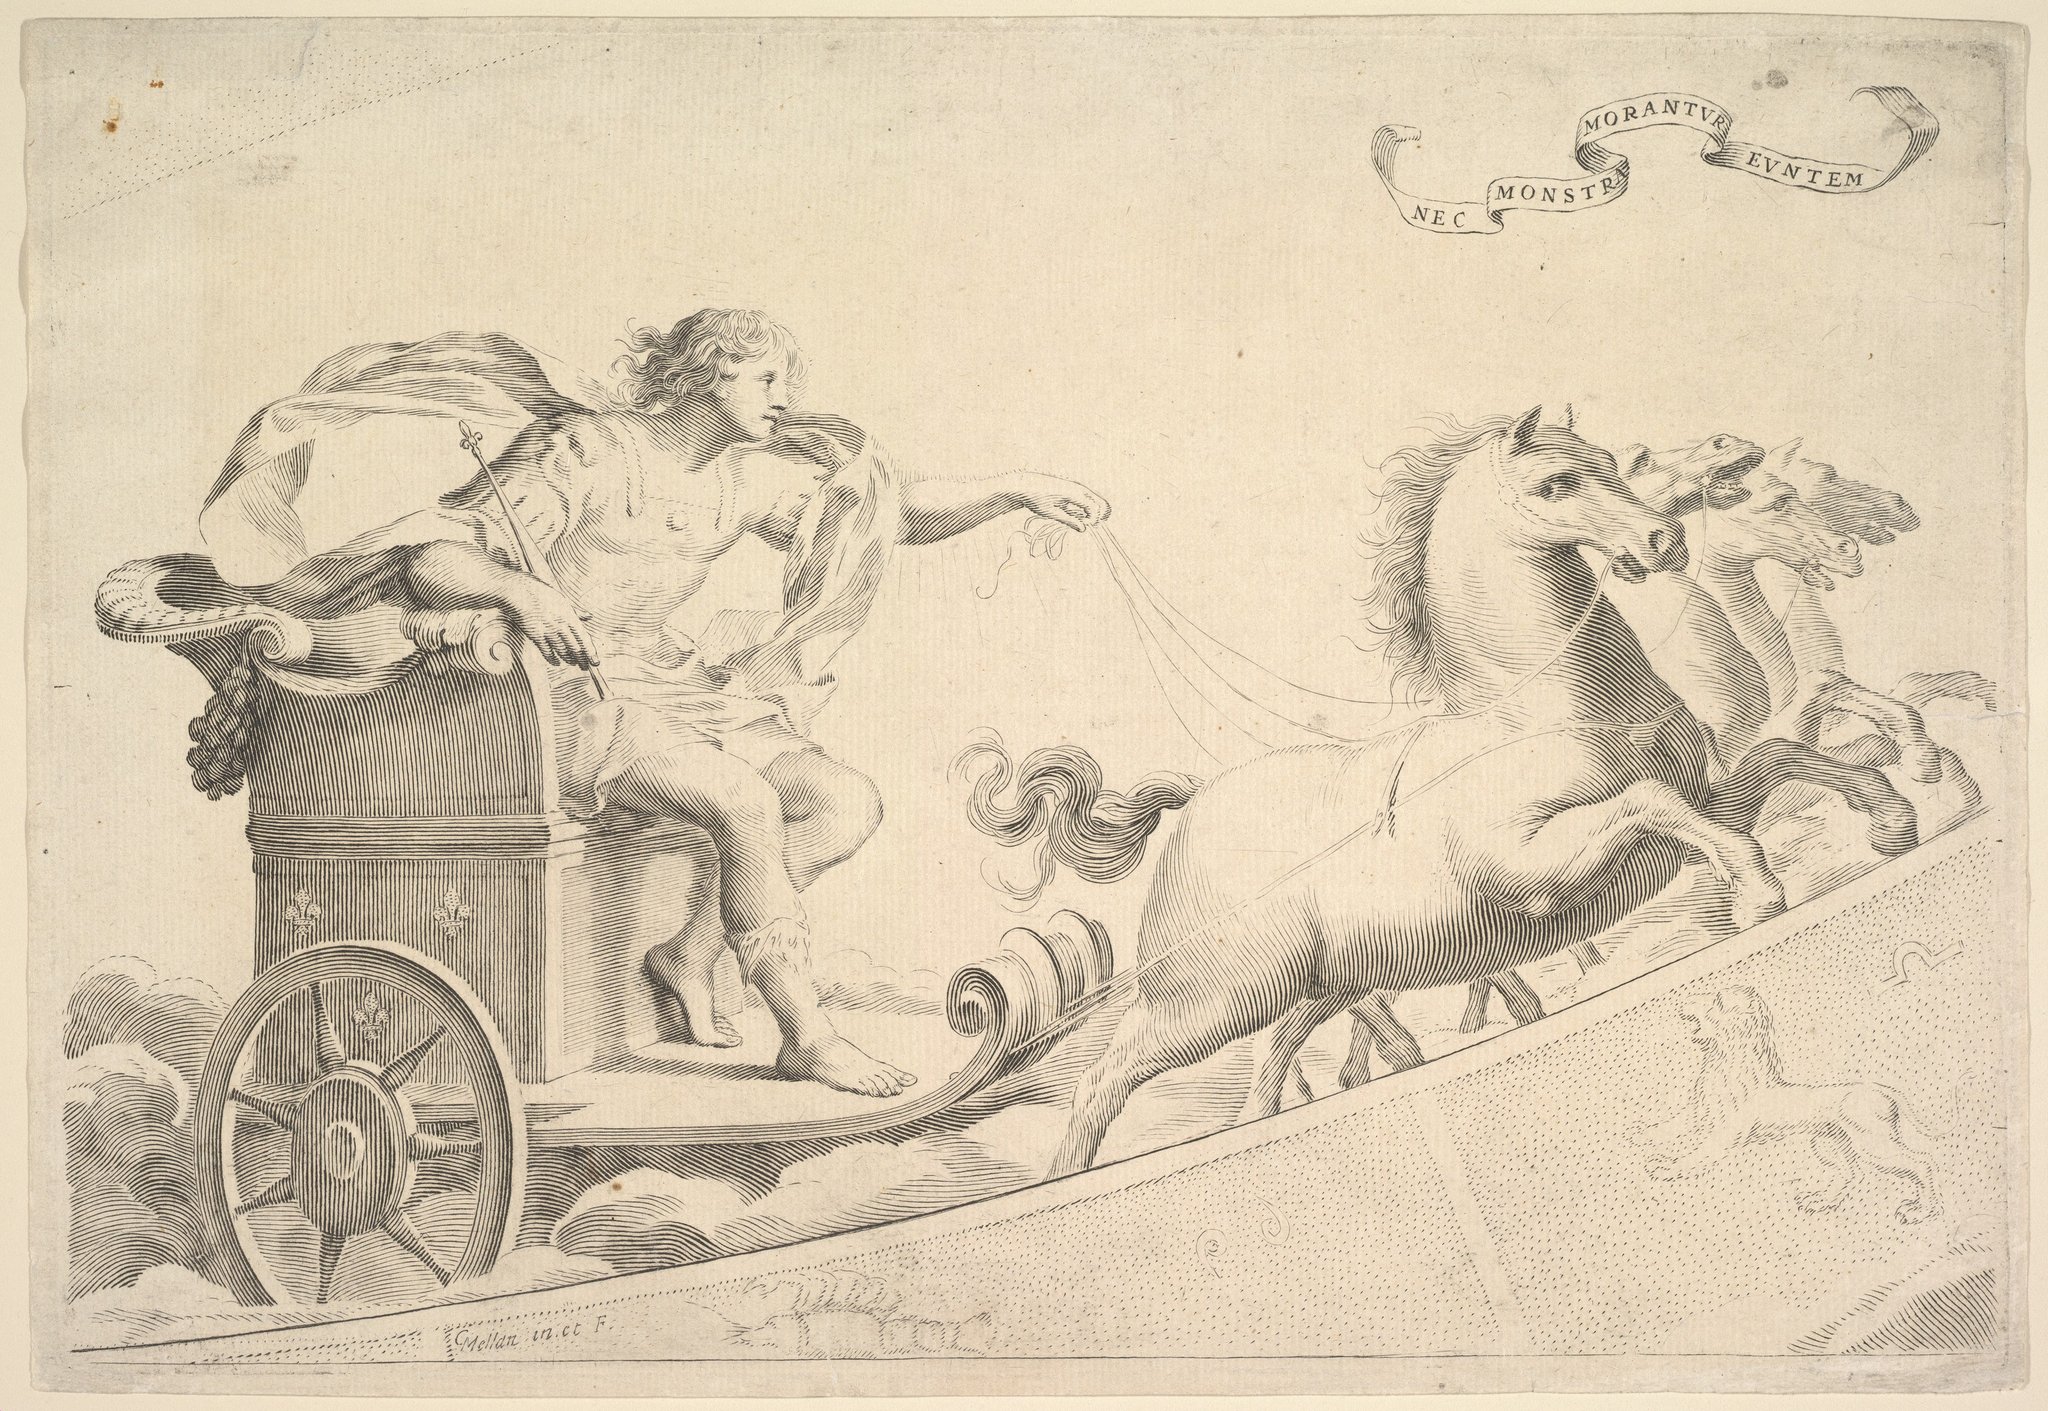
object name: print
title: Allegory in Honor of Louis XIV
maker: claude mellan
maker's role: artist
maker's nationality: french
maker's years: 1598-1688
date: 1600-1688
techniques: engraving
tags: louis xiv,horses,chariots